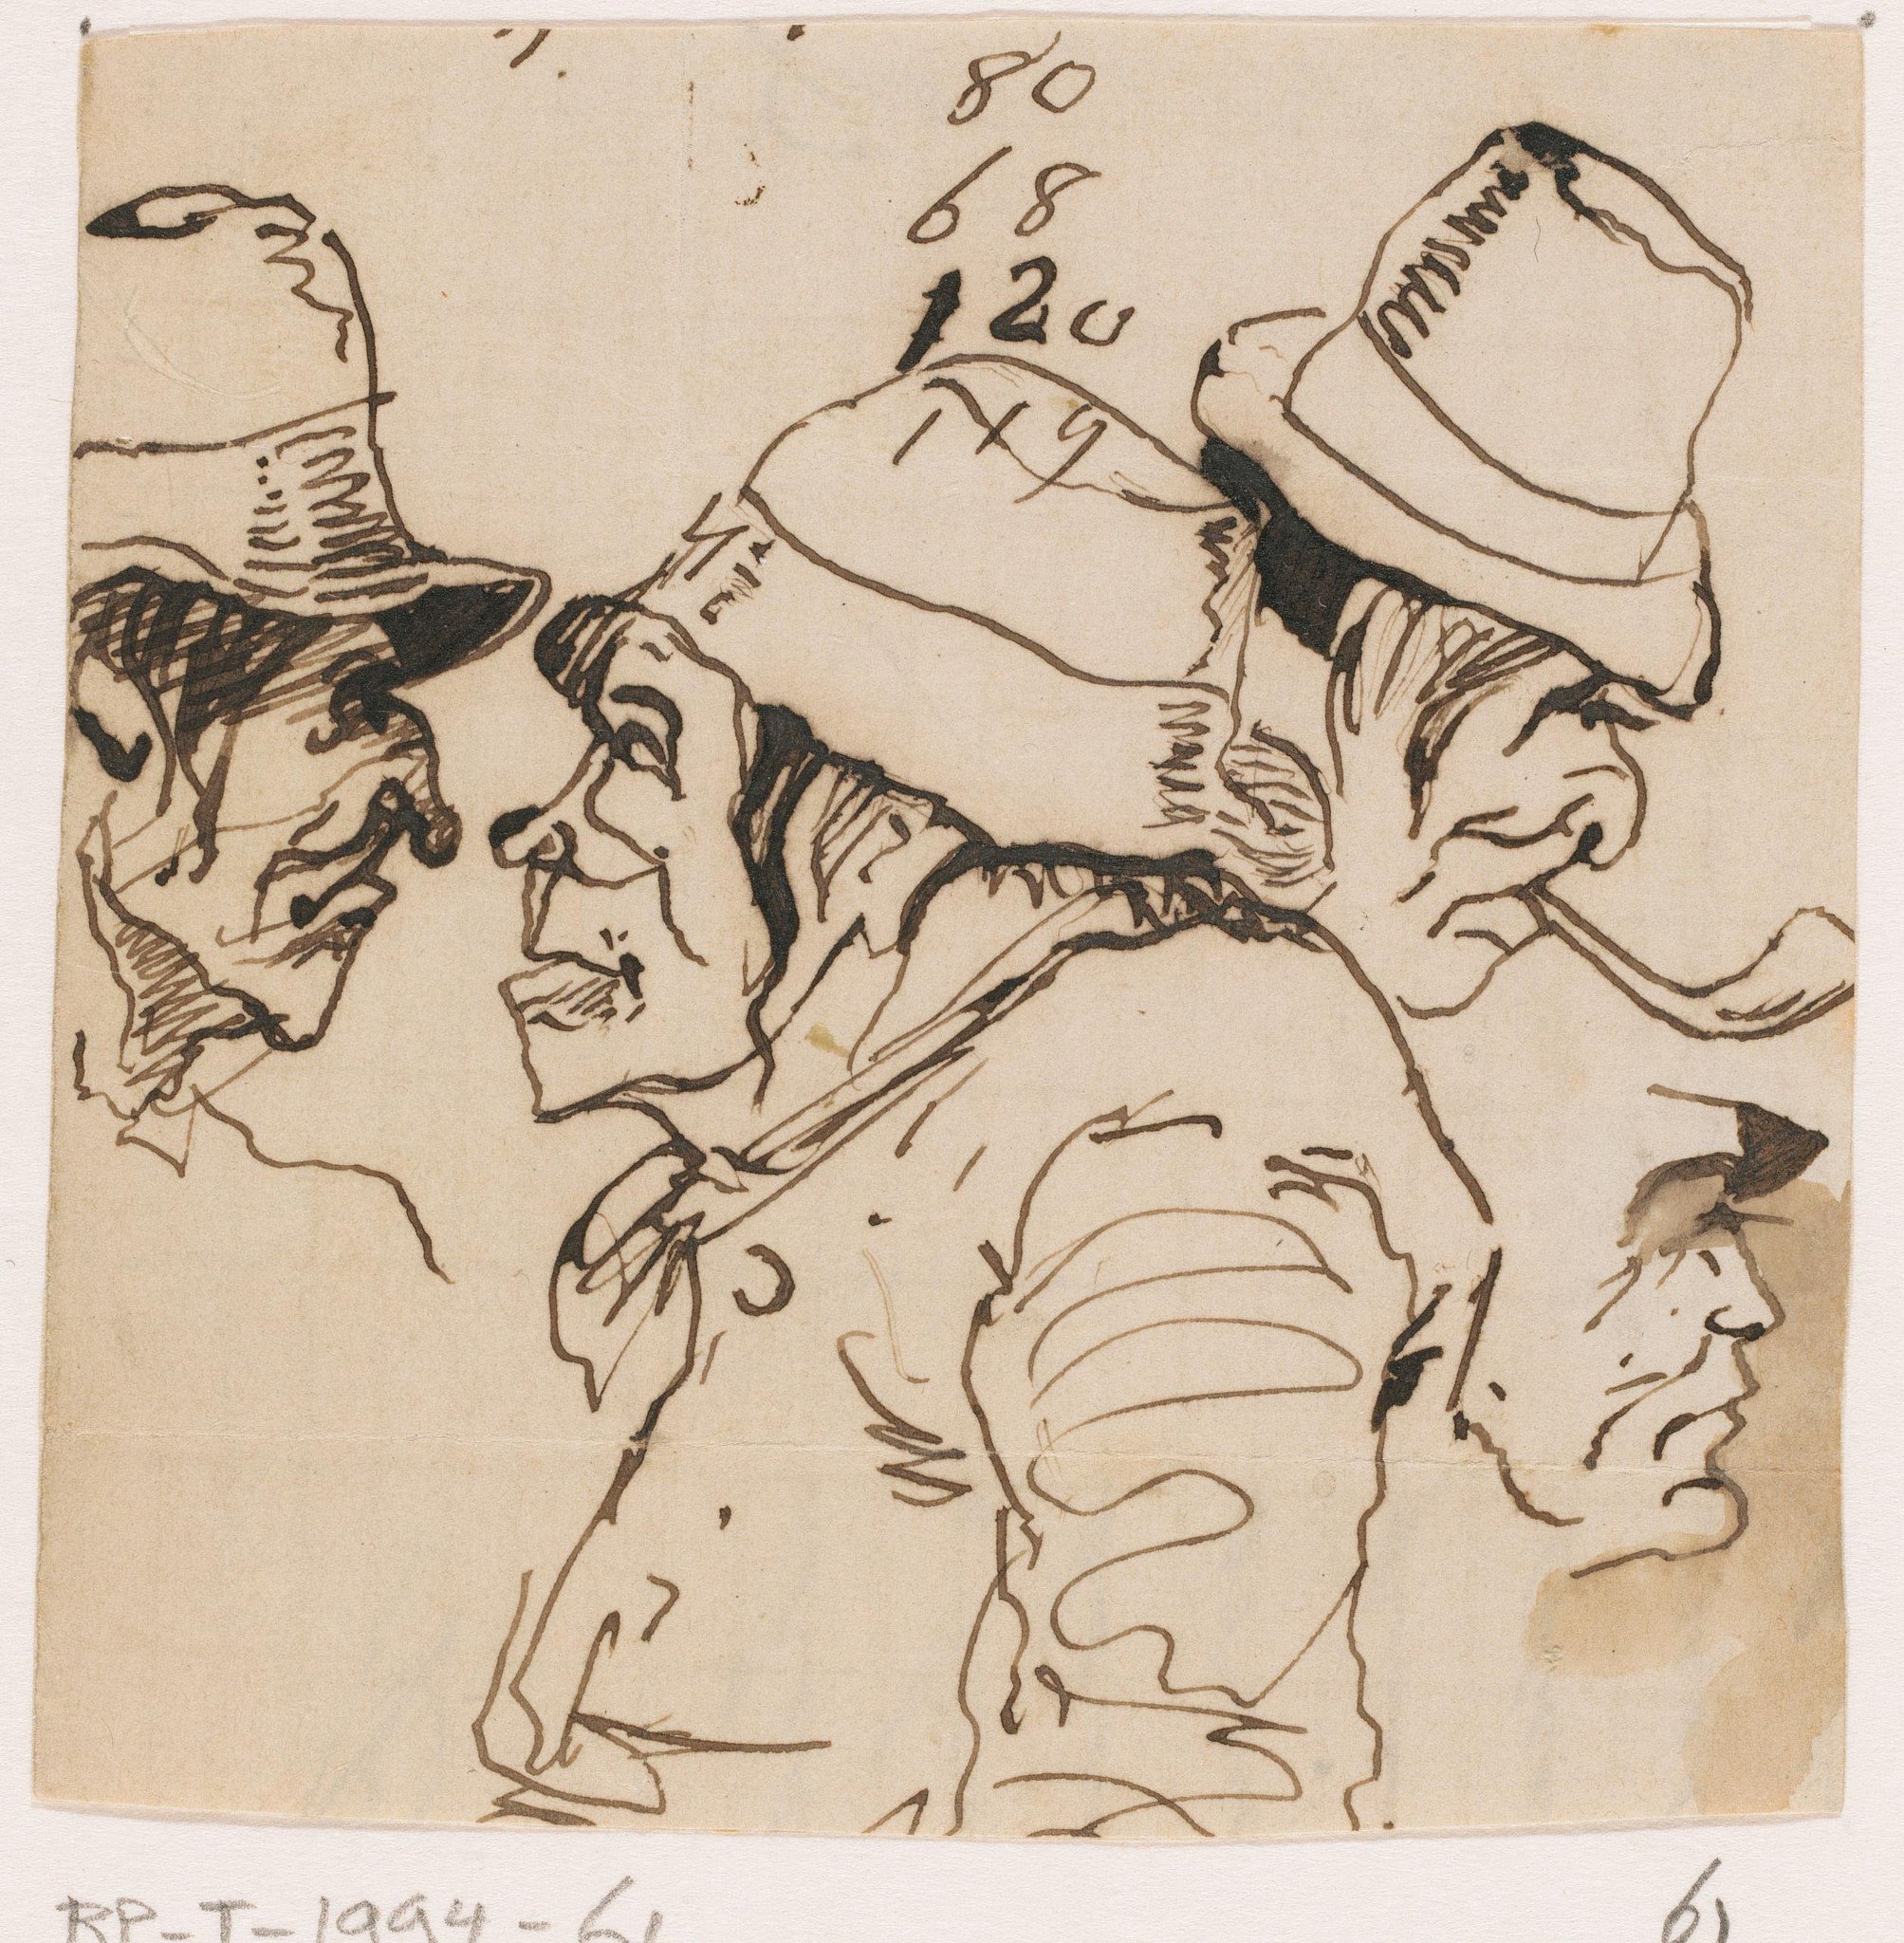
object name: drawing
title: Fragment van een schetsblad met vier karikaturale manskoppen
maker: johannes tavenraat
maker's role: draughtsman, painter, print maker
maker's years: 1809-1881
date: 1819-1881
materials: ink, paper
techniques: pen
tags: caricatures (human types)